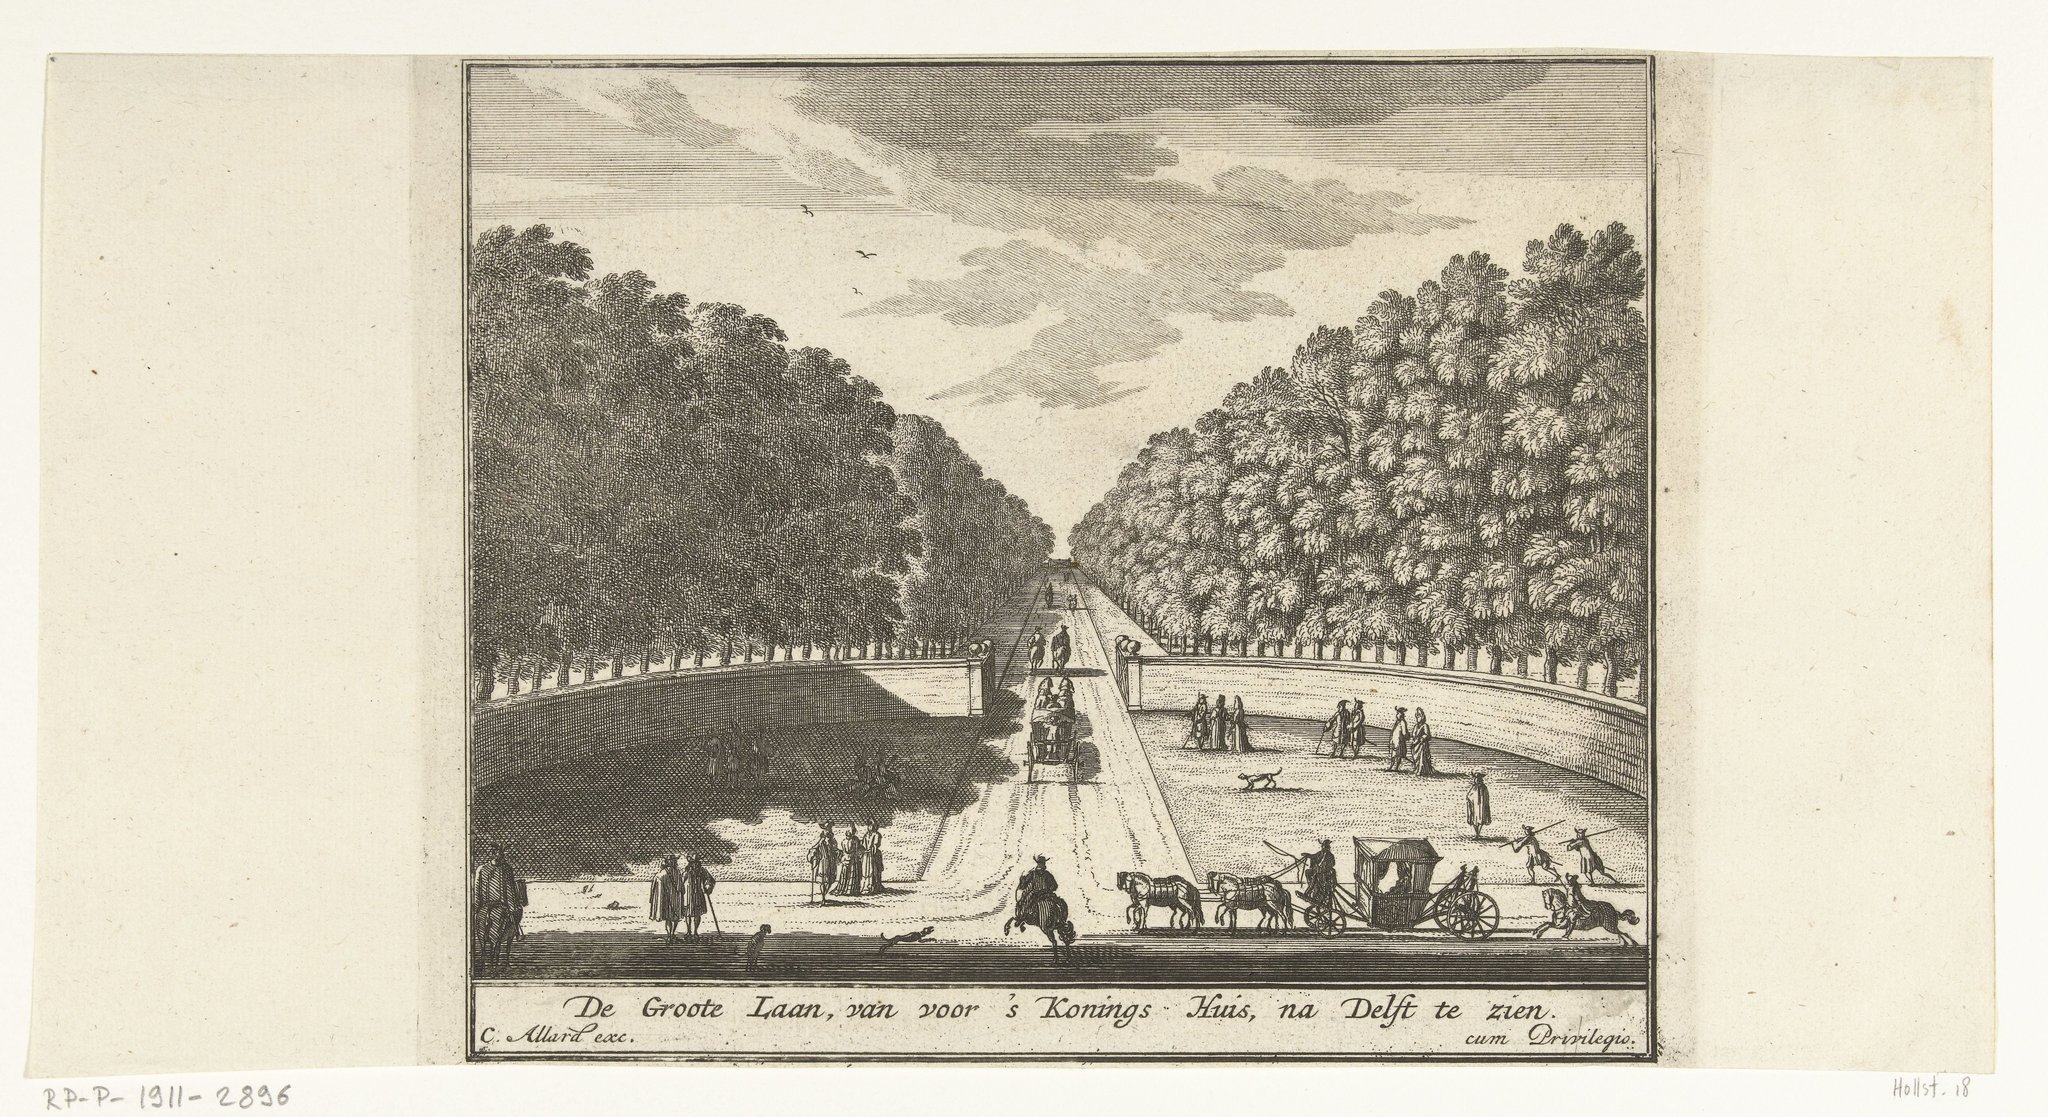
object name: print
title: Hollands Lustpark besluitende zyn Britannische majesteits hof-gebouw tot Honslaardyk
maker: carel allard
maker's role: print maker, publisher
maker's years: 1648-1709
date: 1689-1702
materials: paper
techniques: etching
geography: amsterdam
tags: palace, road, path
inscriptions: collector's mark: Lugt 2228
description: Plein met wandelaars, in het midden de laan voor Paleis Honselaarsdijk richting Delft. Op de laan rijtuigen en ruiters, aan weerszijden bomen. Prent uit een serie van zeventien prenten van Paleis Honselaarsdijk.